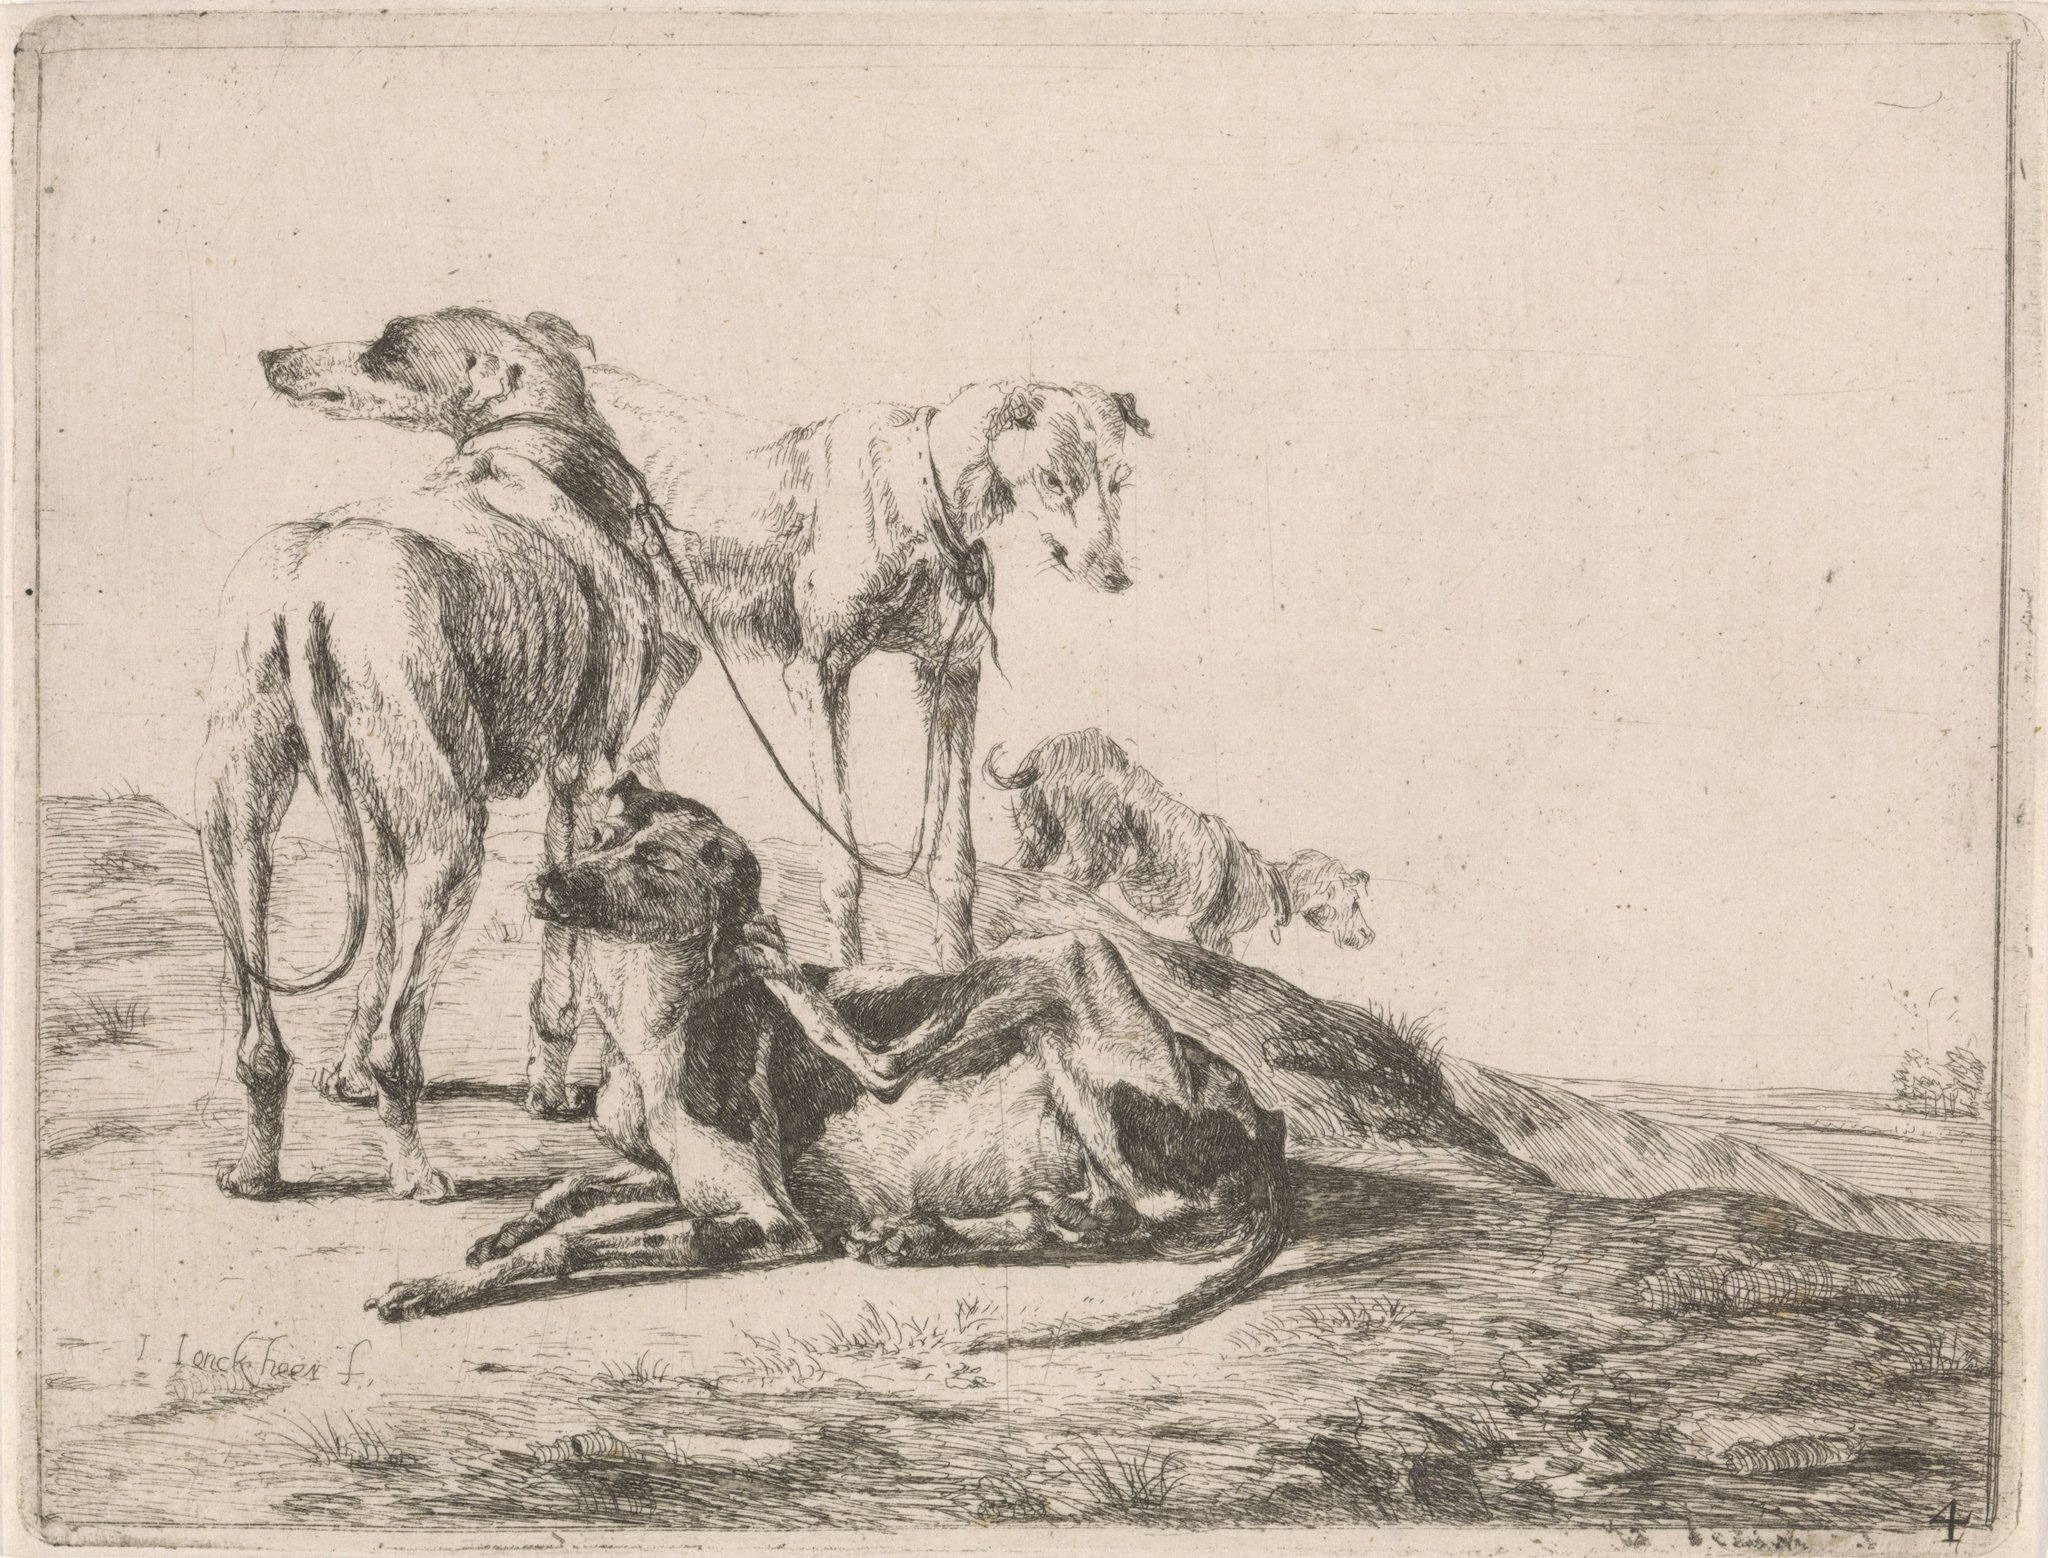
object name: print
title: Landschap met vier hazewindhonden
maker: jacob de jonckheer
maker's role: print maker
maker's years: -1676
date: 1659-1673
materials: paper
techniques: etching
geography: utrecht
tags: dog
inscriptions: collector's mark: Lugt 240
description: Landschap met vier hazewindhonden, één van hen liggend. Vierde prent uit een serie van vier met honden.